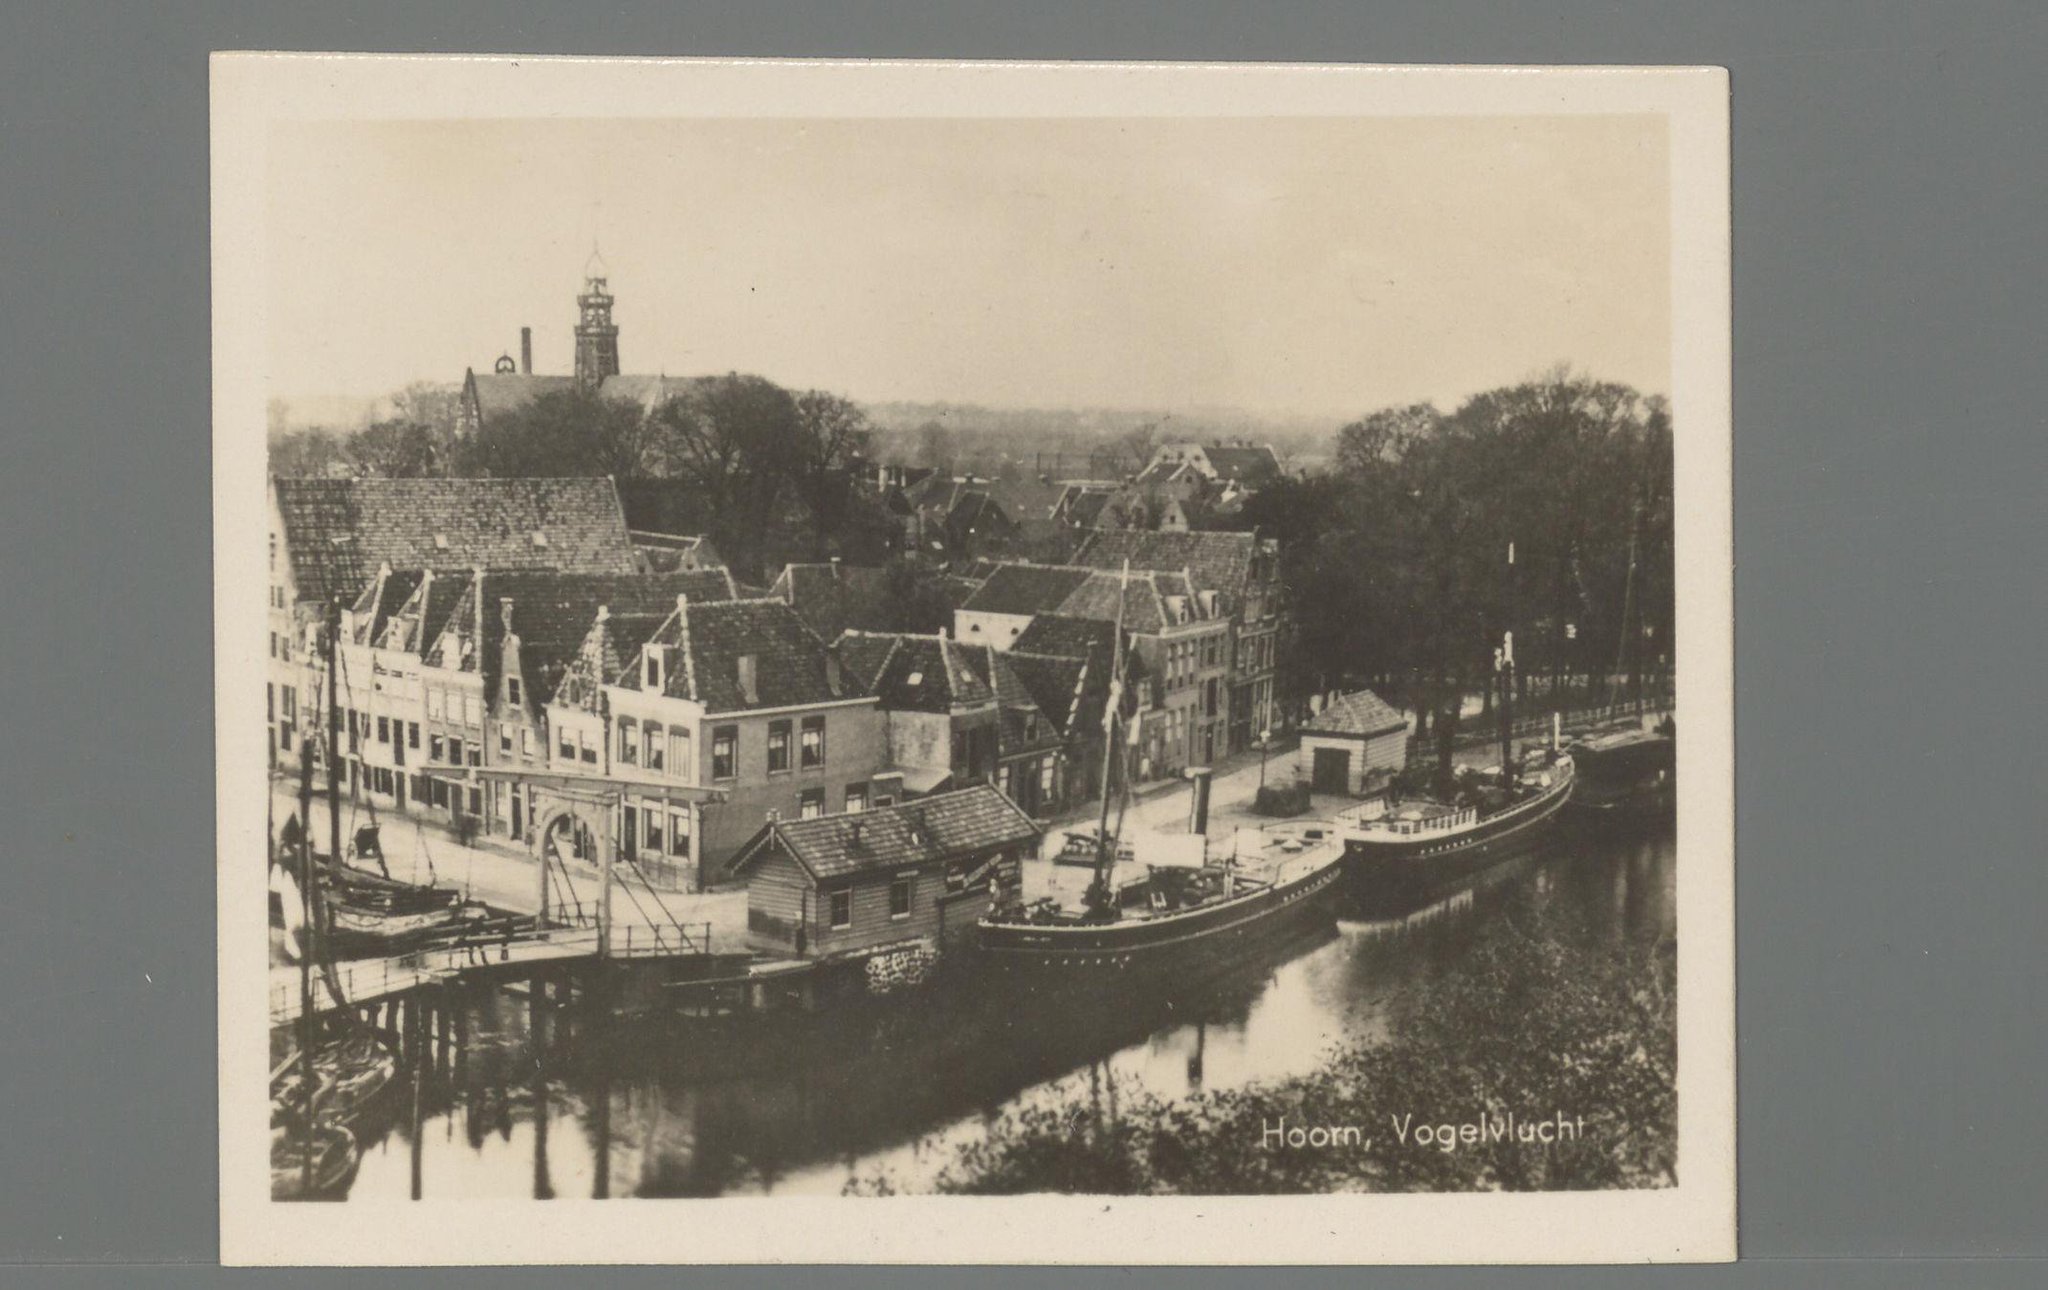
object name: photograph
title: Hoorn, Vogelvlucht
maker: Anonymous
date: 1900-1950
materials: paper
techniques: gelatin silver print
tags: city-view in general; 'veduta', hoorn (north holland)